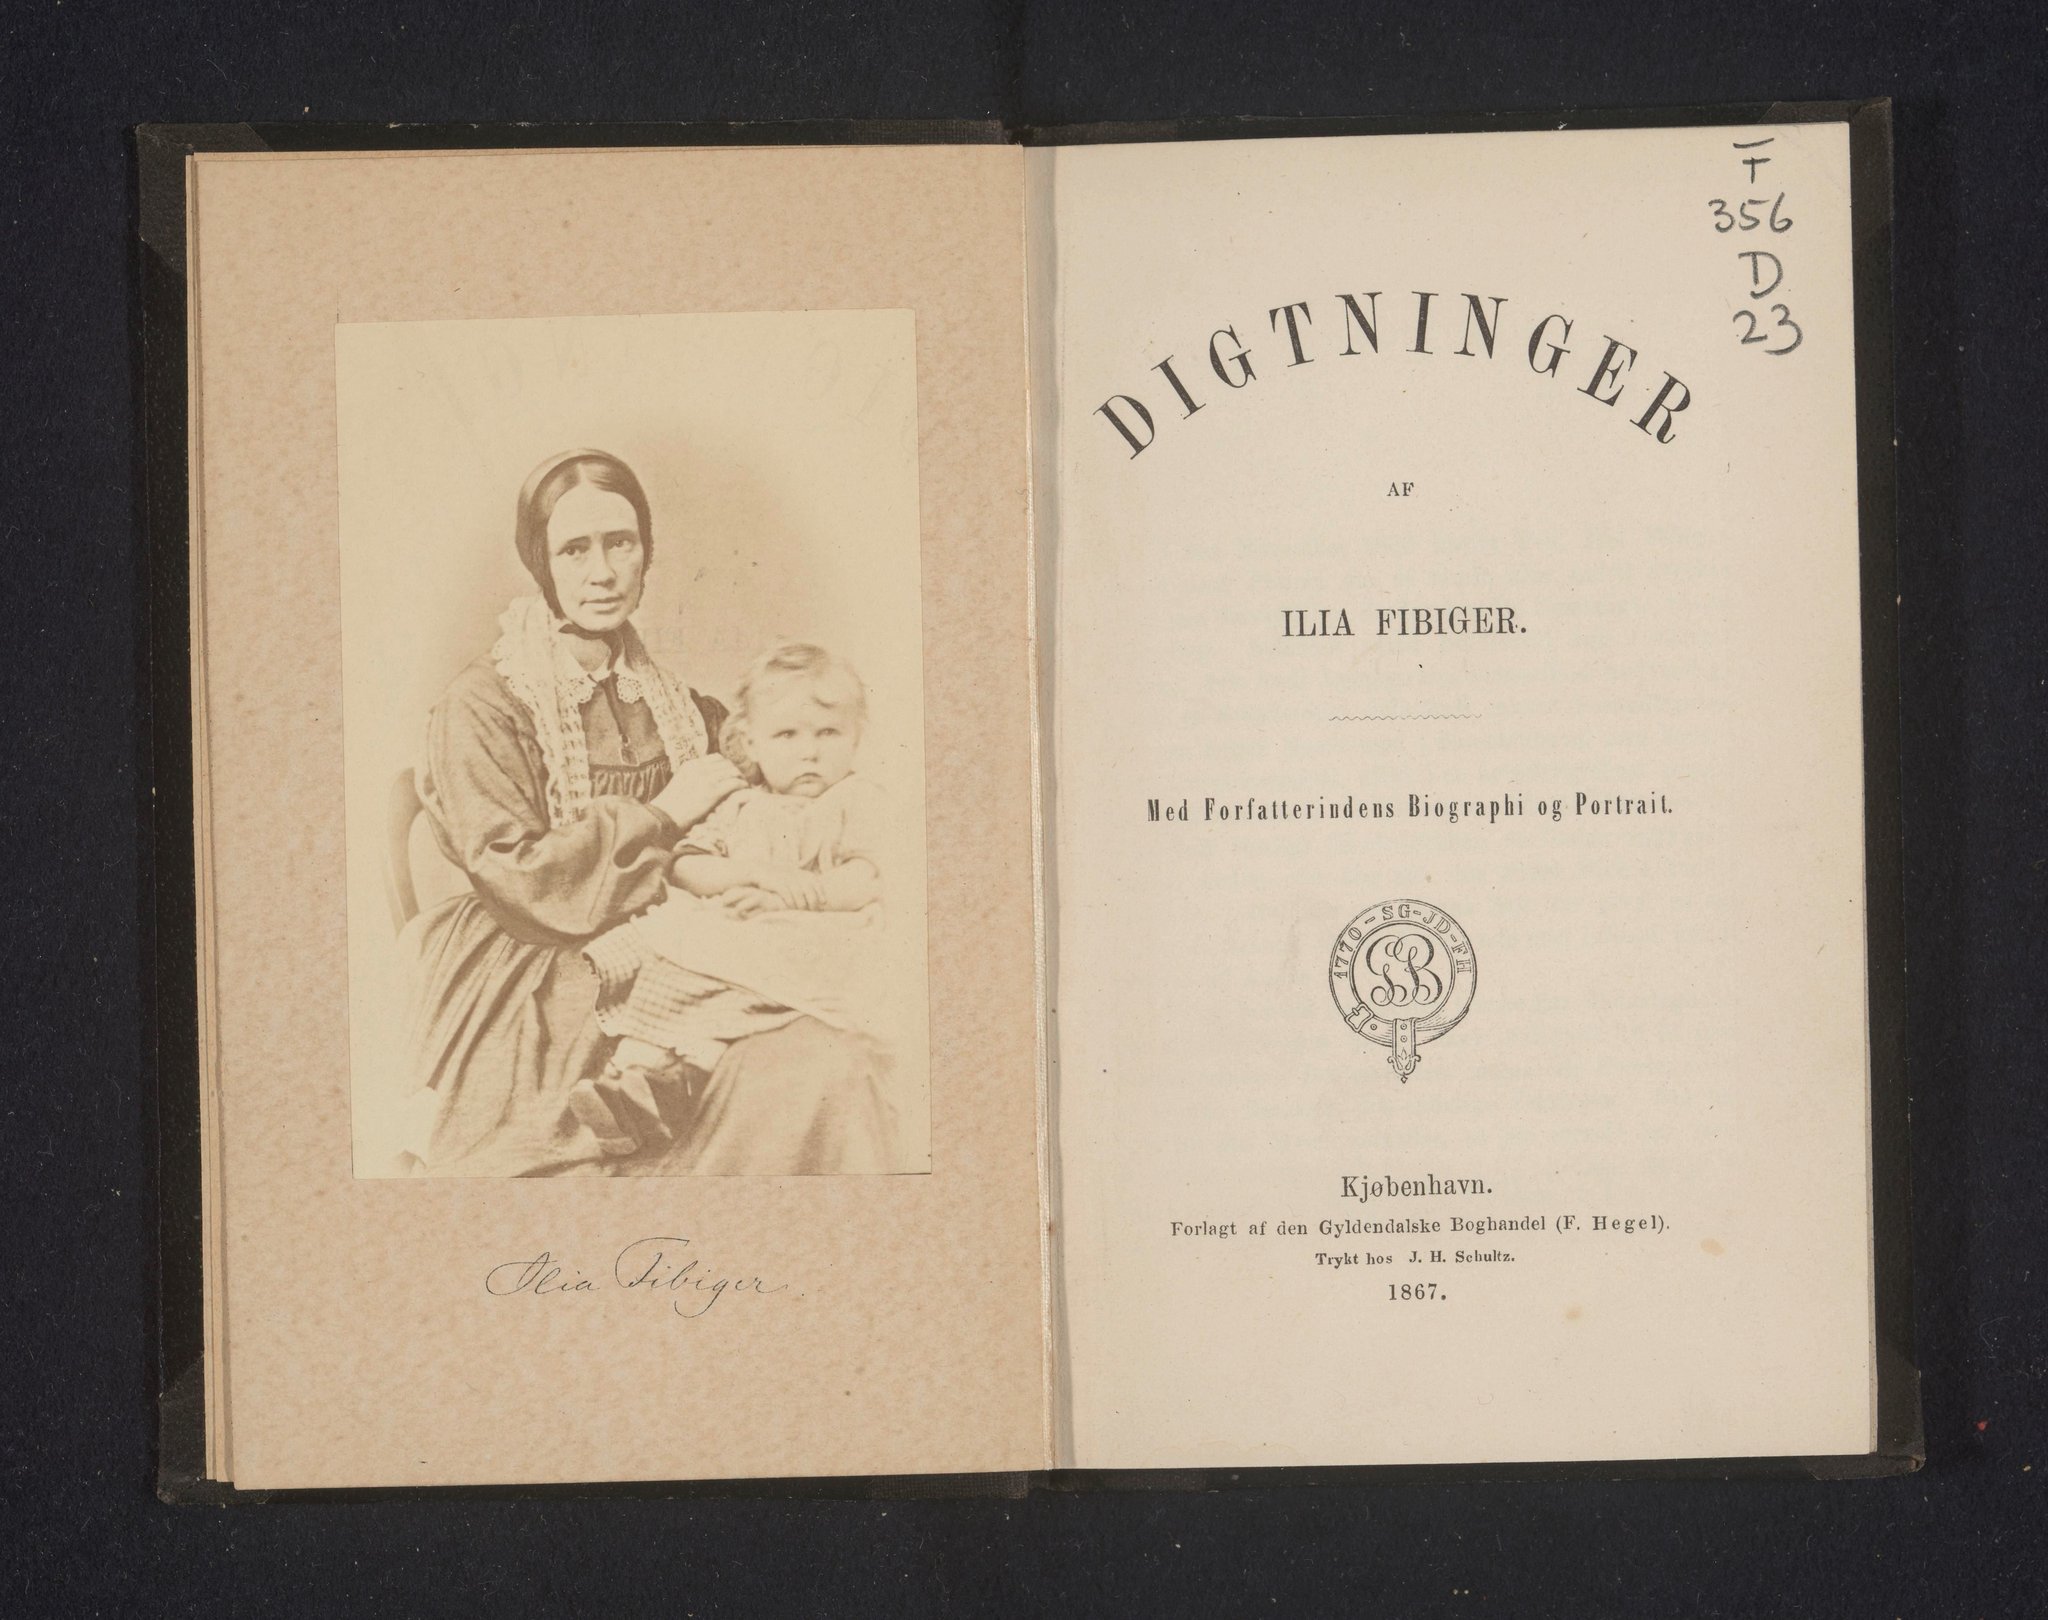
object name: book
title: Digtninger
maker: ilia fibiger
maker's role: schrijver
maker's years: 1817-1867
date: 1867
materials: cardboard, linen, paper, photographic support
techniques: albumen print, printing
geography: copenhagen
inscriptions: name: ‘Maria Philipsen[...] Ibsen’